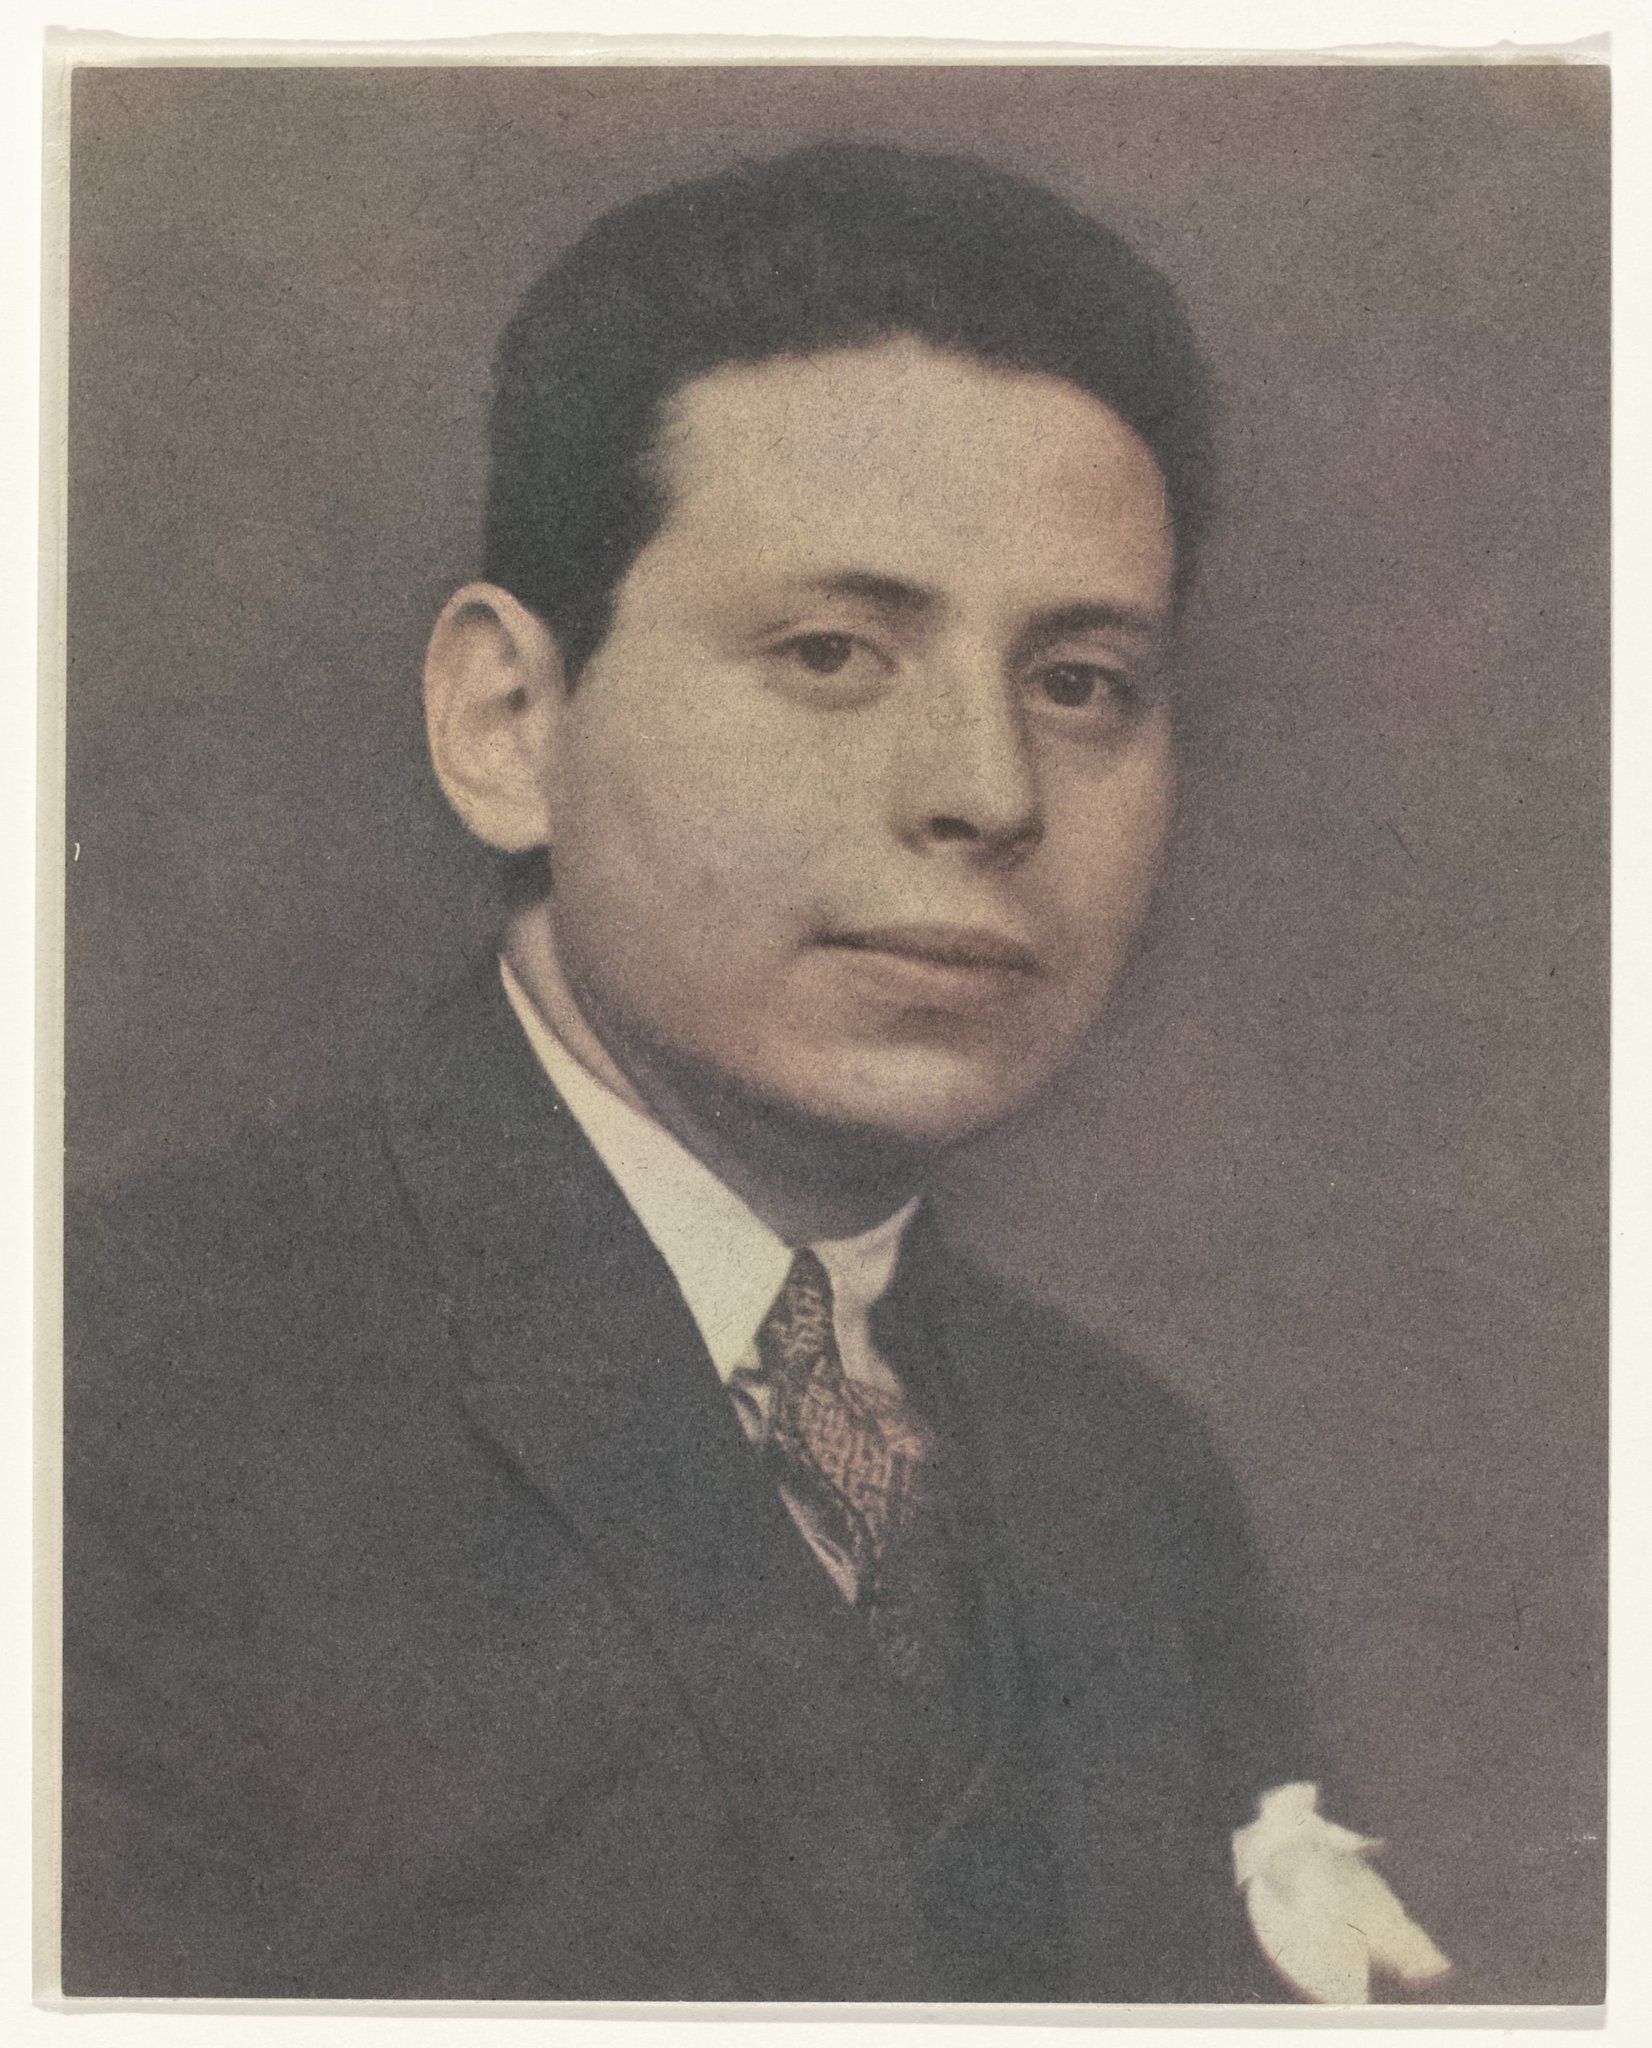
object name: photograph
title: Portret van Ernst Fischel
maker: jacob merkelbach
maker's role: fotograaf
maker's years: 1877-1942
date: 1920-1930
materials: paper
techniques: bromoil process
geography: amsterdam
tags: historical persons (portraits and scenes from the life)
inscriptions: inscription: ‘Foto Merkelbach van Ernst Finschel broomverfoverdruk’, annotation: ‘drie overlijdensberichten van Ernst Fischel in het Rotterdams dagblad’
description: Portret van Ernst Fischel van de foto-groothandel.